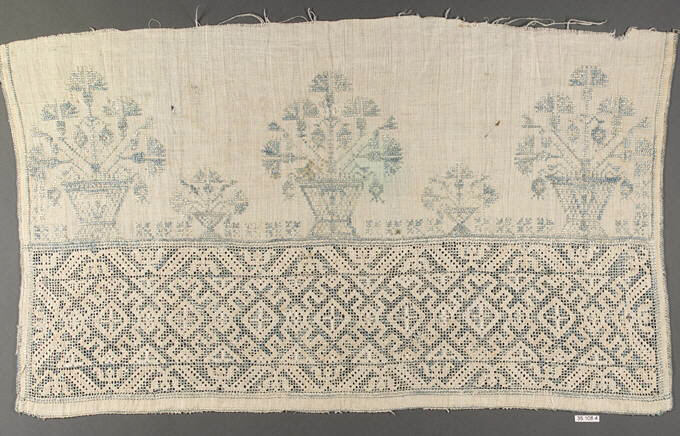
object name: cover fragment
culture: mexican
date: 1801-1900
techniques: embroidery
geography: mexico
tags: plants